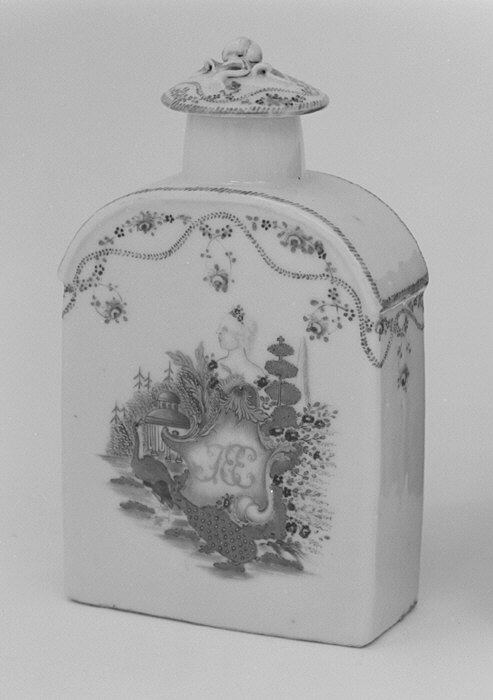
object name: tea caddy with cover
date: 1780-1790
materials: hard paste porcelain